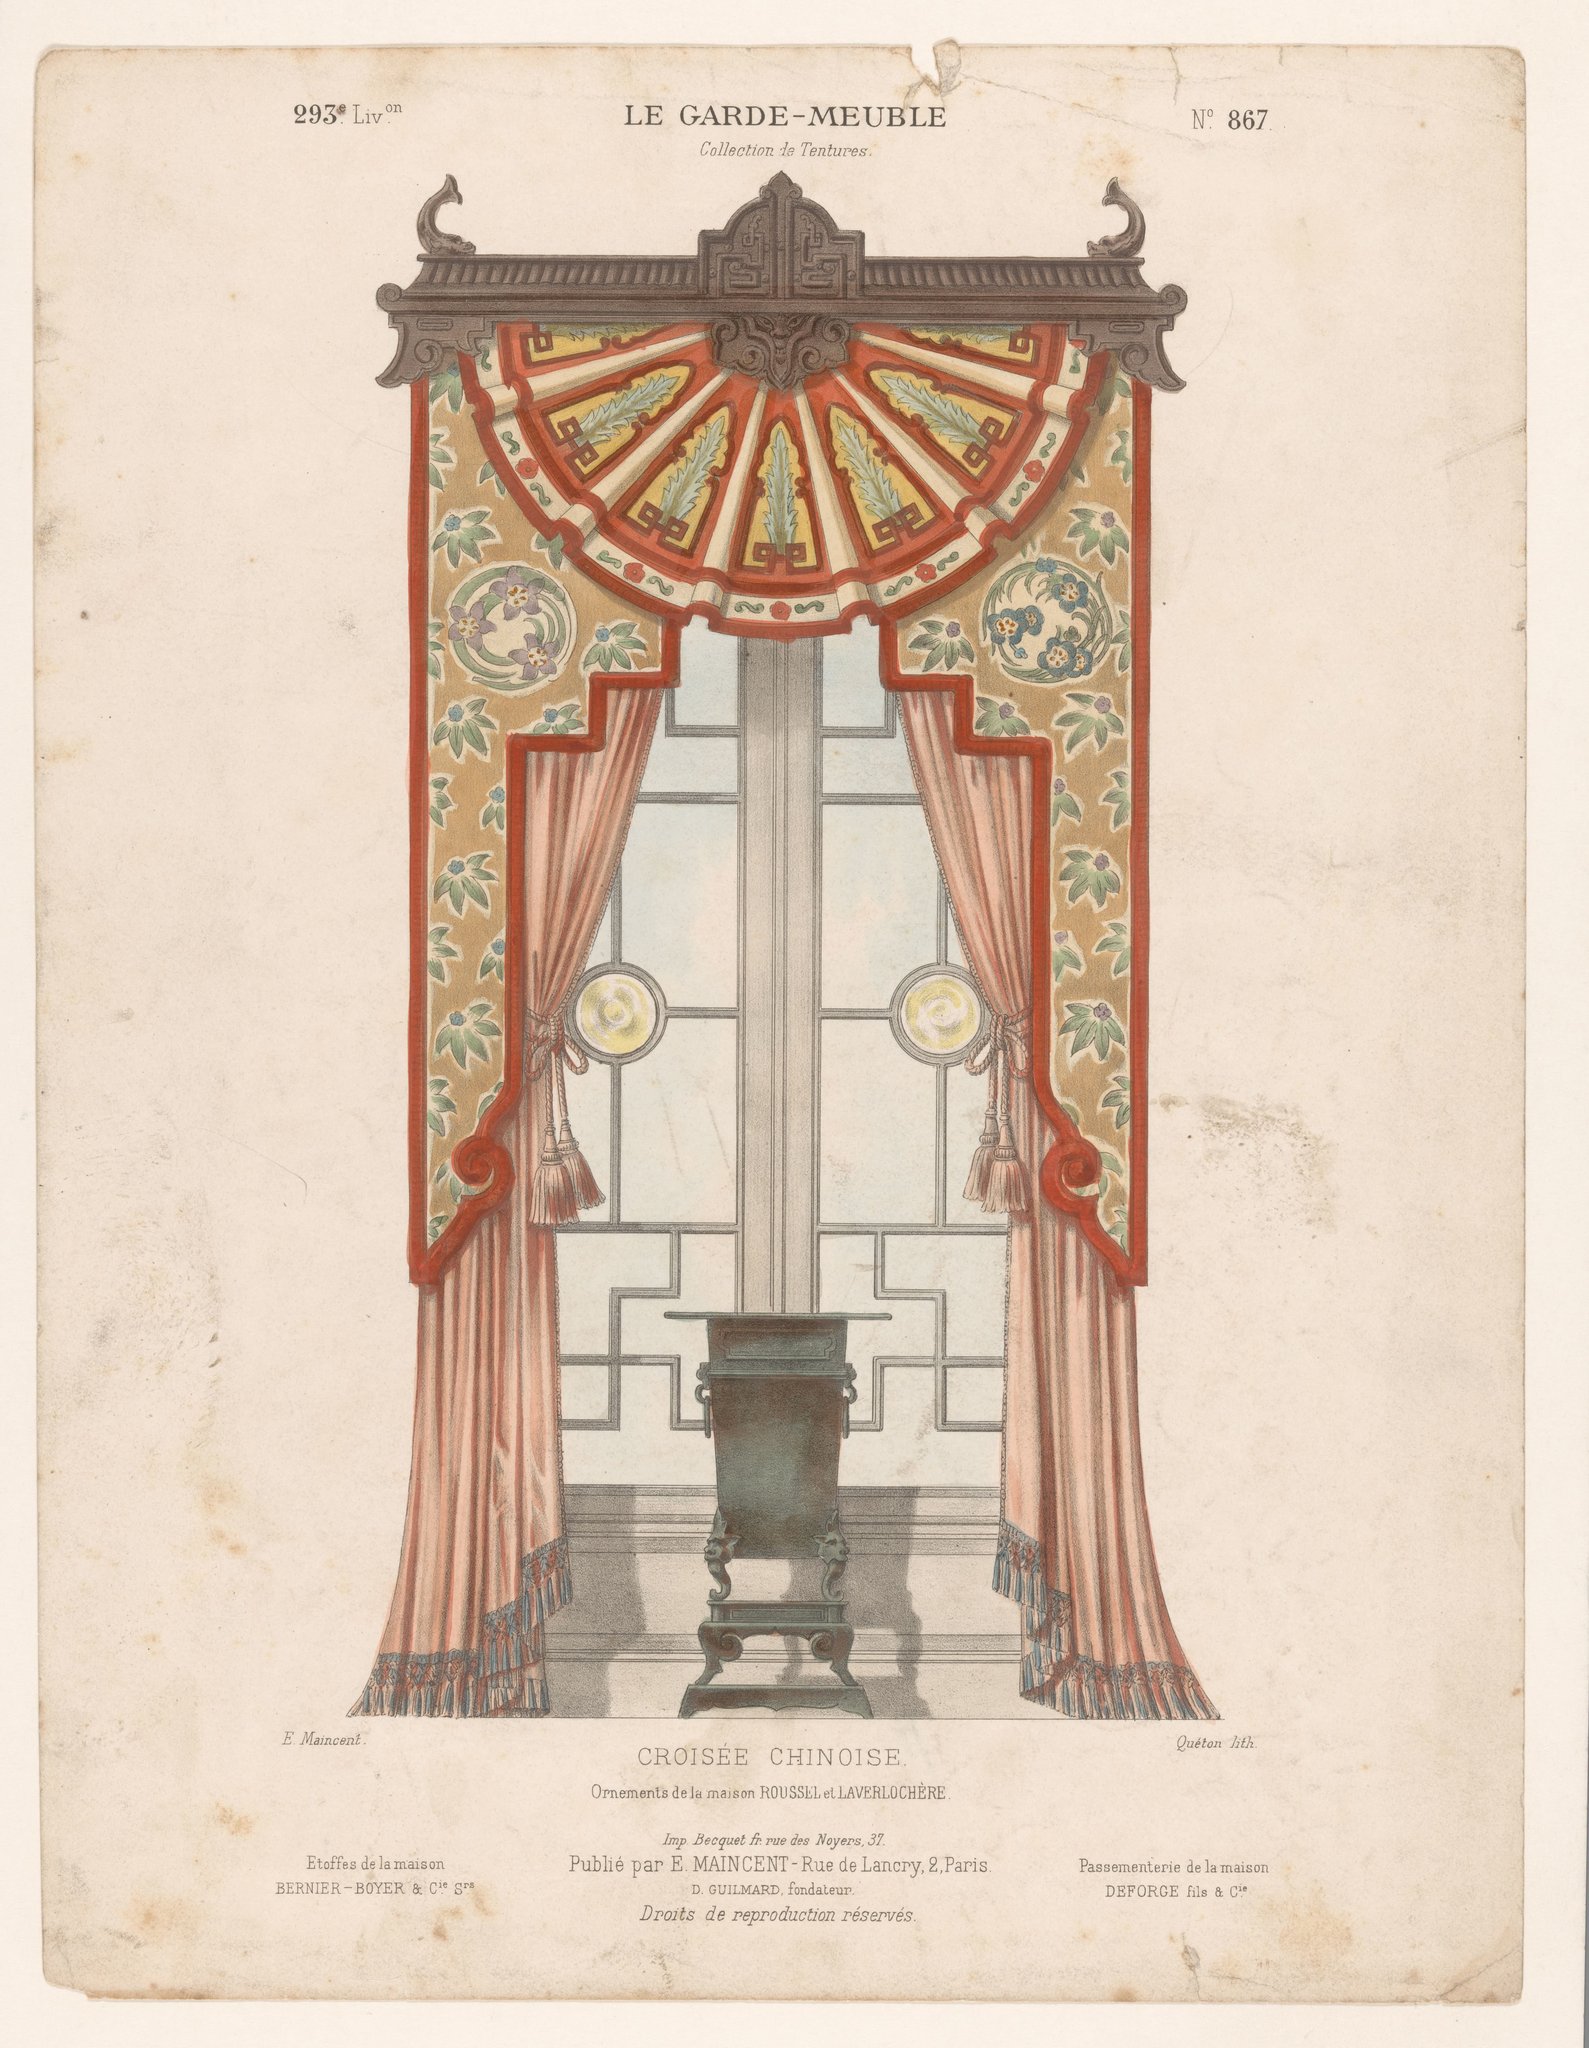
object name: print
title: Venster met gordijnen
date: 1885-1895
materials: paper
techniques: hand coloring, lithograph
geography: paris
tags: window, hangings and drapery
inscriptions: : ‘Droits de reproduction réservés.’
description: Kruisvenster met gedrapeerde gordijnen in Chinese stijl. Prent uit 293e Livraison.